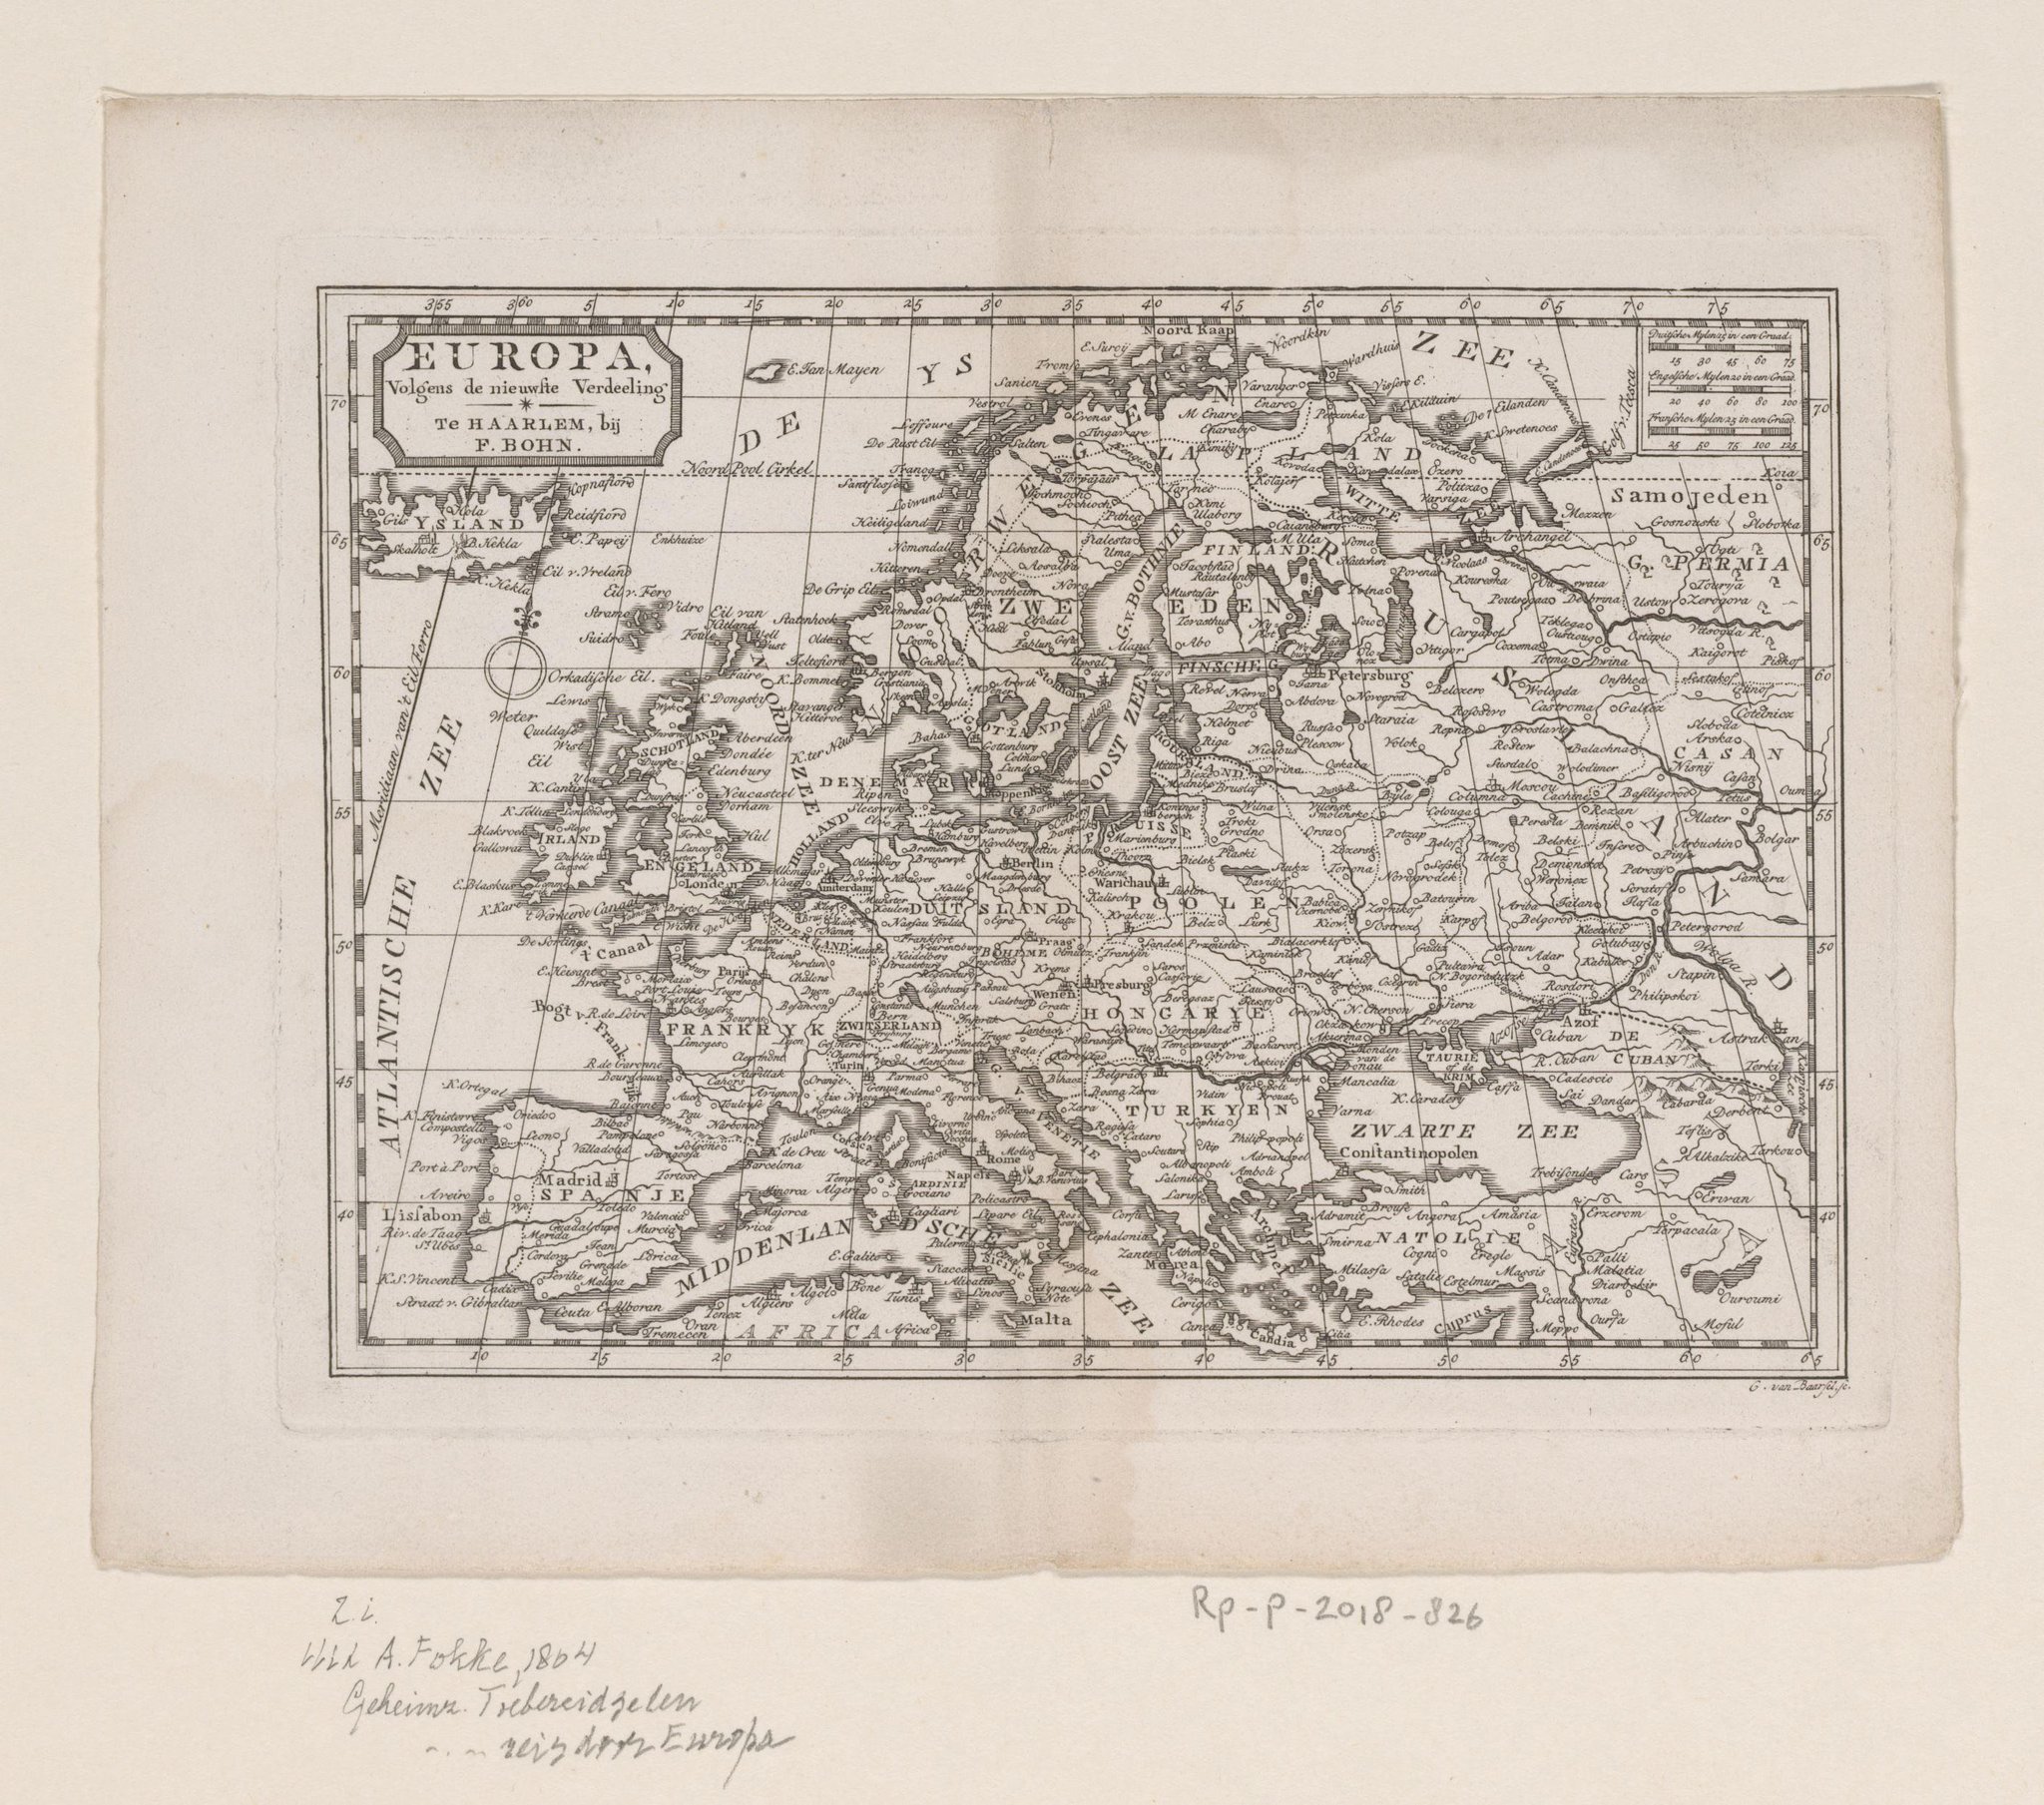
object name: map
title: Europa volgens de nieuwste verdeeling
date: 1804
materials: paper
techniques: engraving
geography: amsterdam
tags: (map of) europe, europe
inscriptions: collector's mark: Lugt 2228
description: Kaart van Europa. Linksboven de titelcartouche. De kaart is voorzien van een coördinaten-net en een gradenverdeling langs de randen. Rechtsboven een kader met drie schaalstokken.